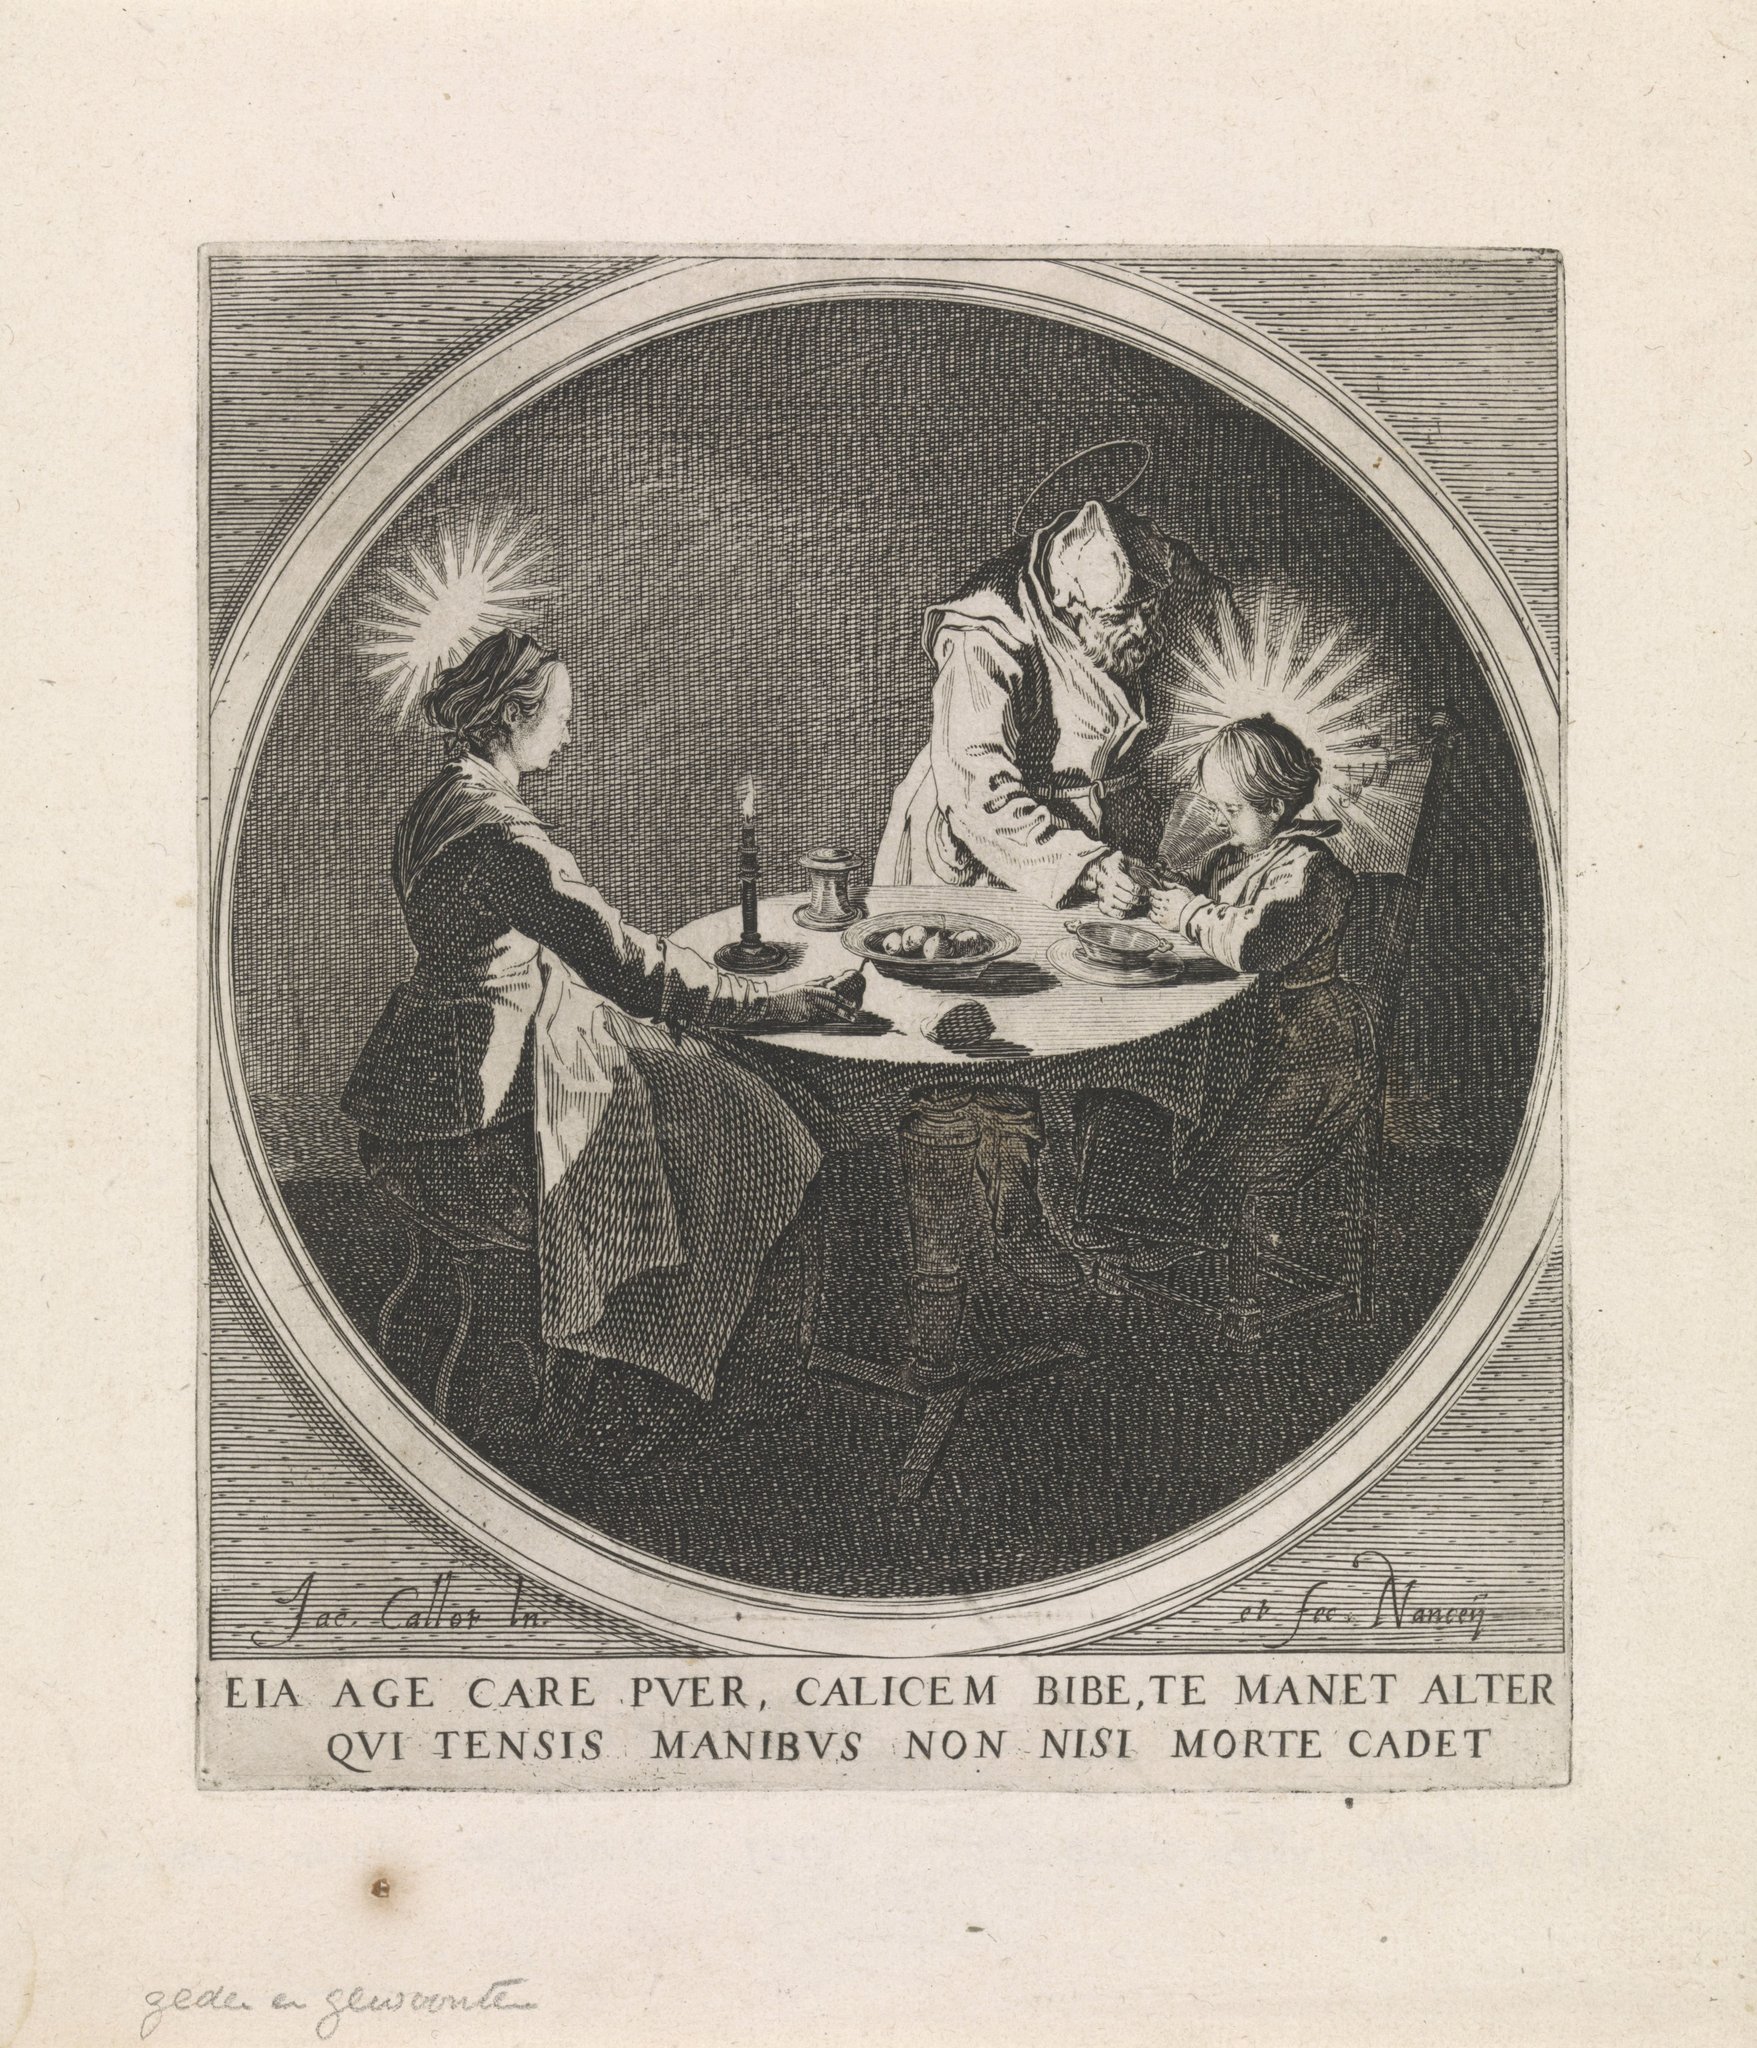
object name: print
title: Heilige Familie aan tafel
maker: jacques callot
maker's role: draughtsman, print maker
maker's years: 1592-1635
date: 1628-1629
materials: paper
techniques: etching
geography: nancy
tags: holy family, and derived representations, (family) meal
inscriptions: collector's mark: Lugt 2233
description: Aan een ronde tafel zit de maagd Maria (links) tegenover de kleine Christus (rechts), die door Jozef geholpen wordt bij het drinken uit een glas. Voorstelling is gevat in ronde omlijsting die zelf weer in vierkant kader is geplaatst. Eronder een tweeregelig onderschrift in Latijn.